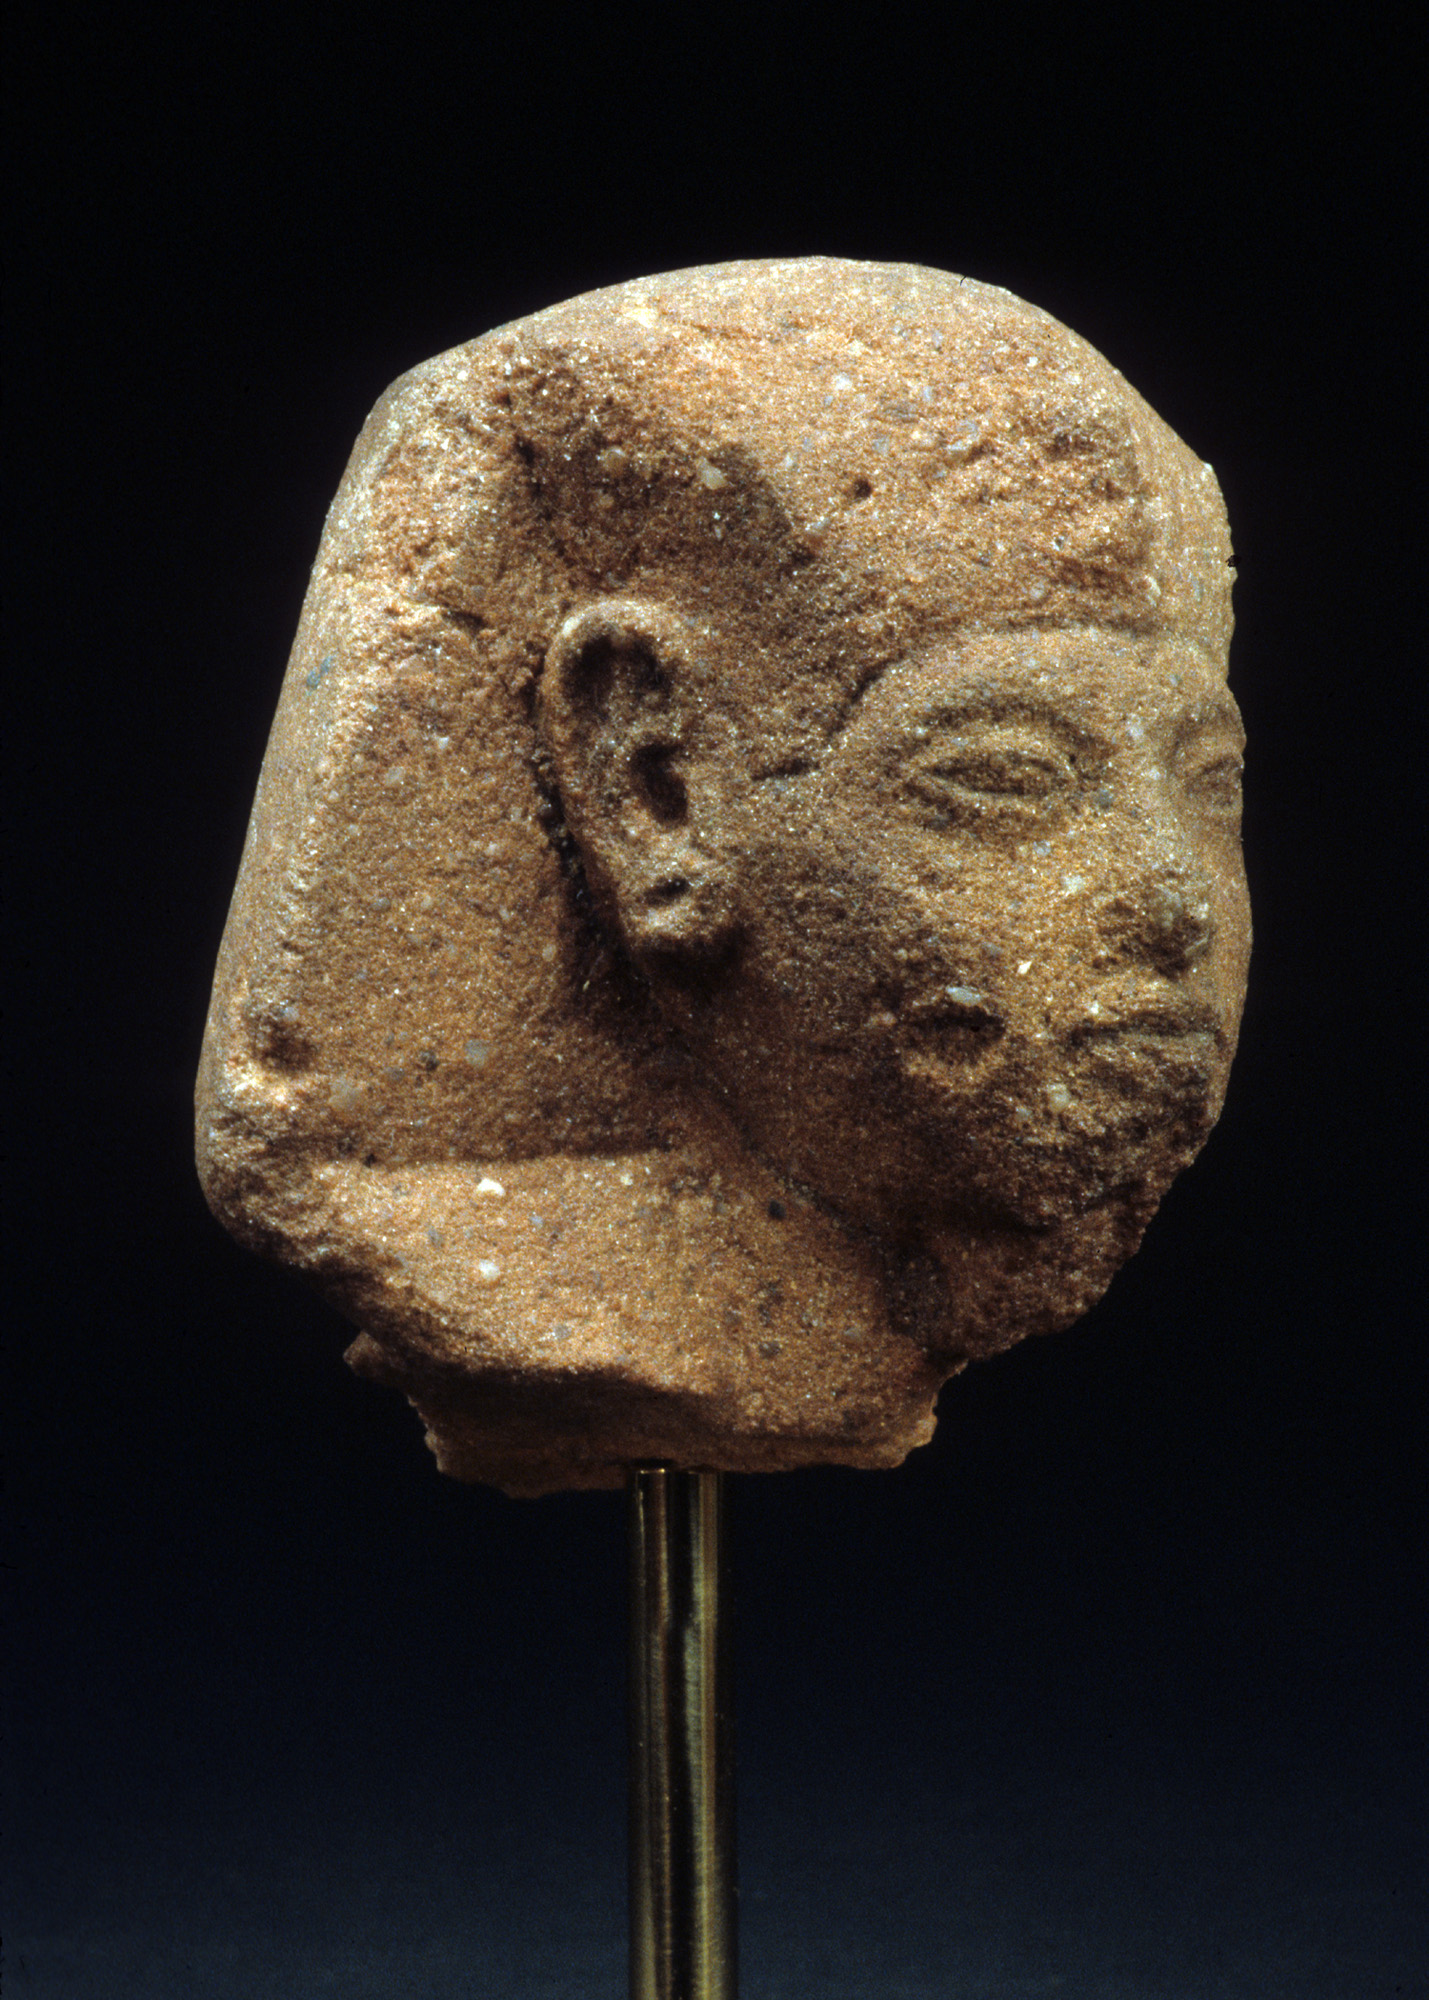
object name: funerary figure, shabti, akhenaten, head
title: Head of a Funerary Figure of Akhenaten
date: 1353-1336 BCE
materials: stone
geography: middle egypt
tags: heads